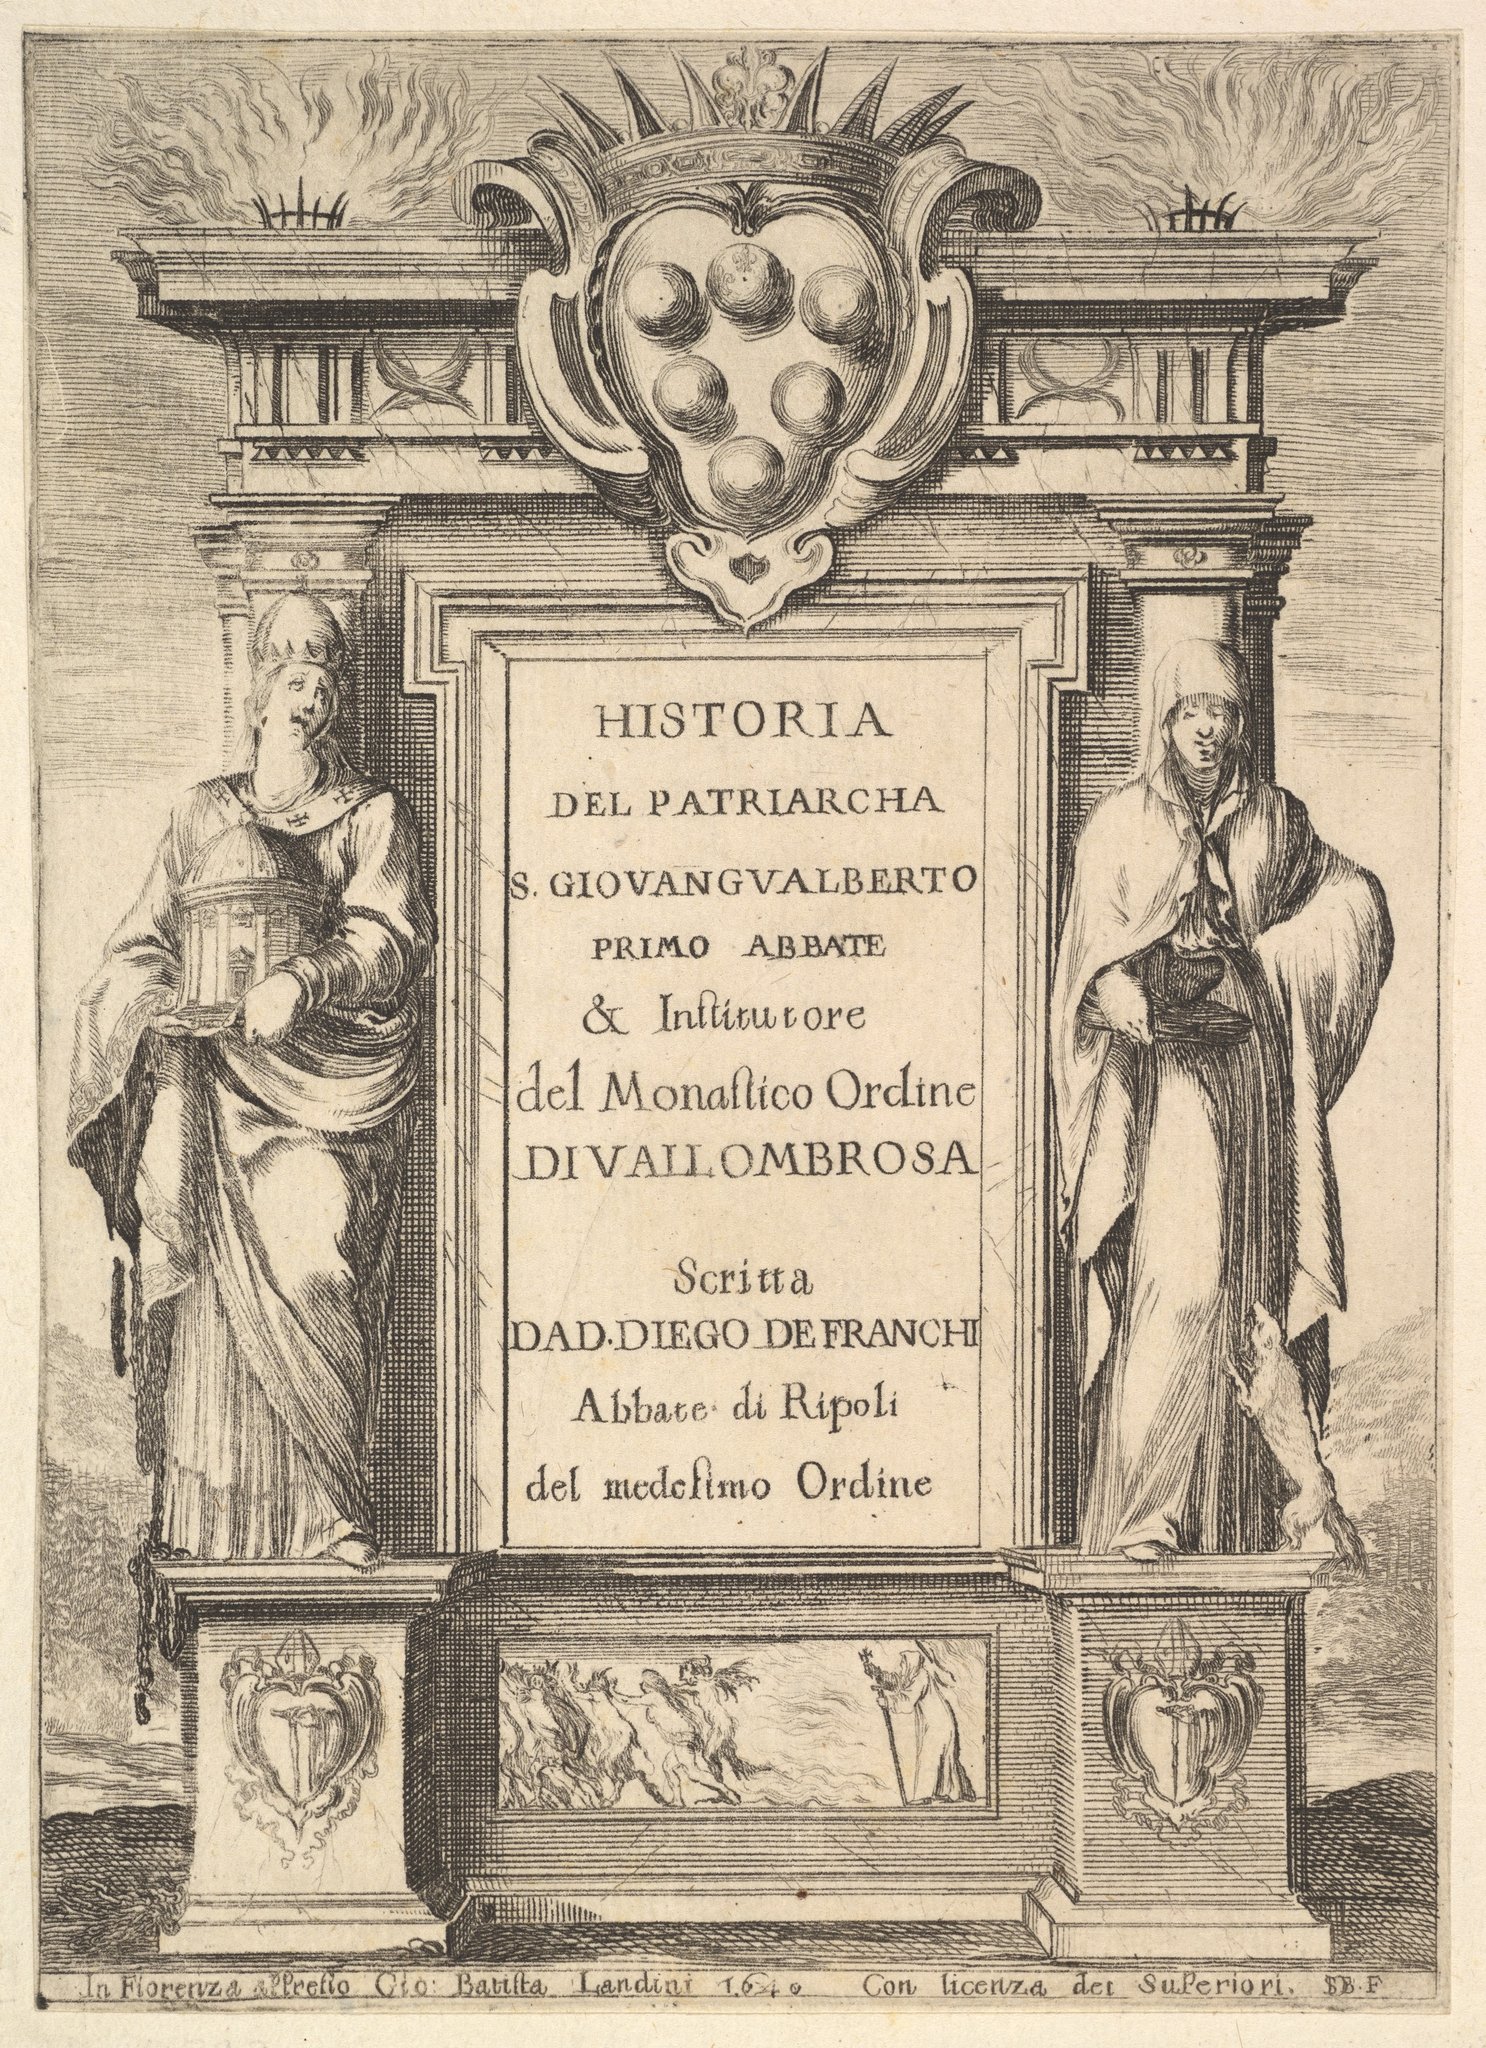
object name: print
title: Frontispiece, from "Frontispiece and four scenes from the life of Saint John Gualbert" (Frontispice et quatre vignettes pour une vie de Saint Jean Gualbert)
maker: stefano della bella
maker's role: artist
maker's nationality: italian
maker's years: 1610-1664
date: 1640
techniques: etching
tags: human figures,monuments,saints,coat of arms